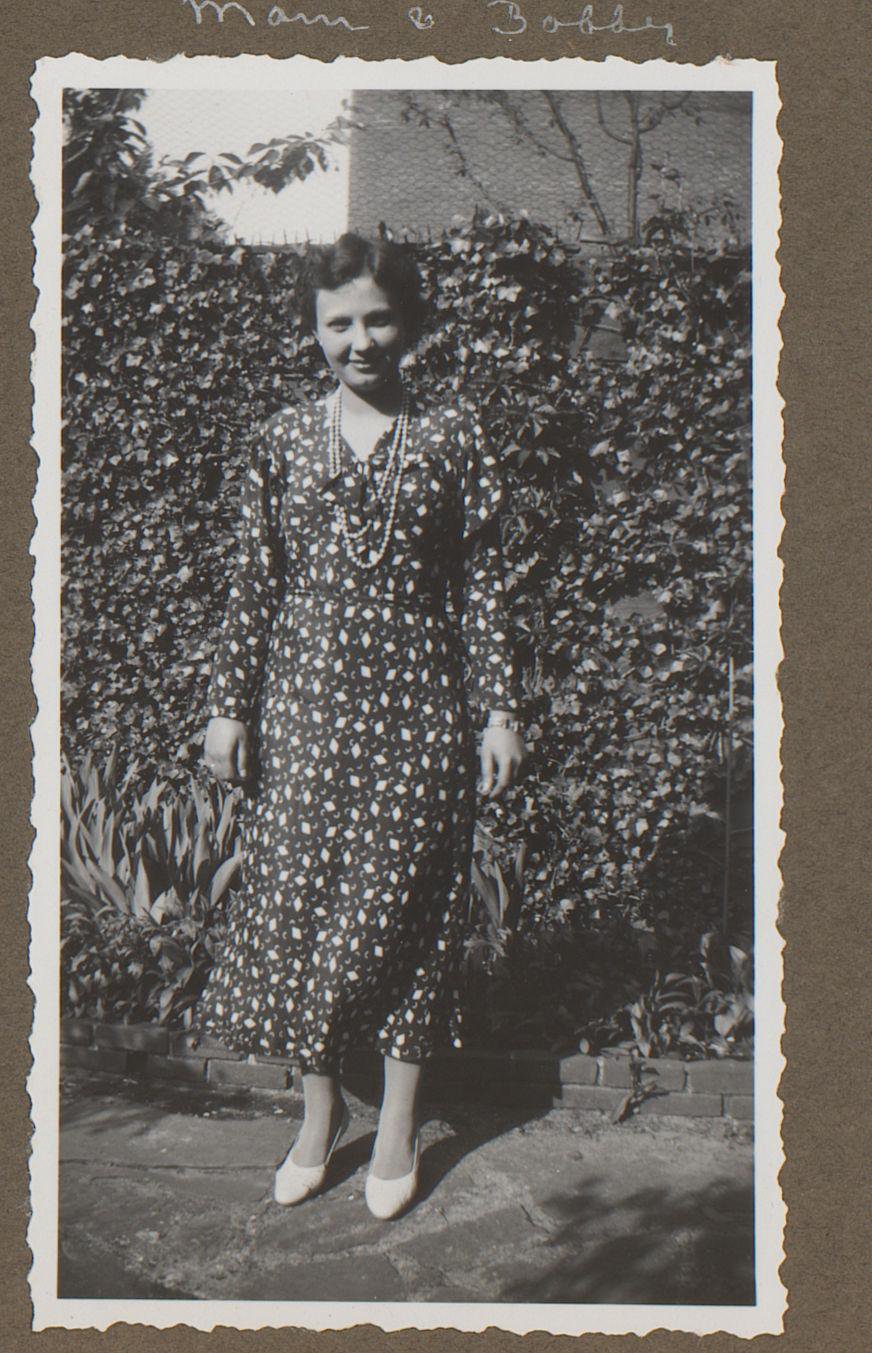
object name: photograph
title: Portret van een vrouw staand in een tuin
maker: Anonymous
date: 1934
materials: paper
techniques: gelatin silver print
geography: netherlands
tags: historical persons not known by name - bb - woman, netherlands